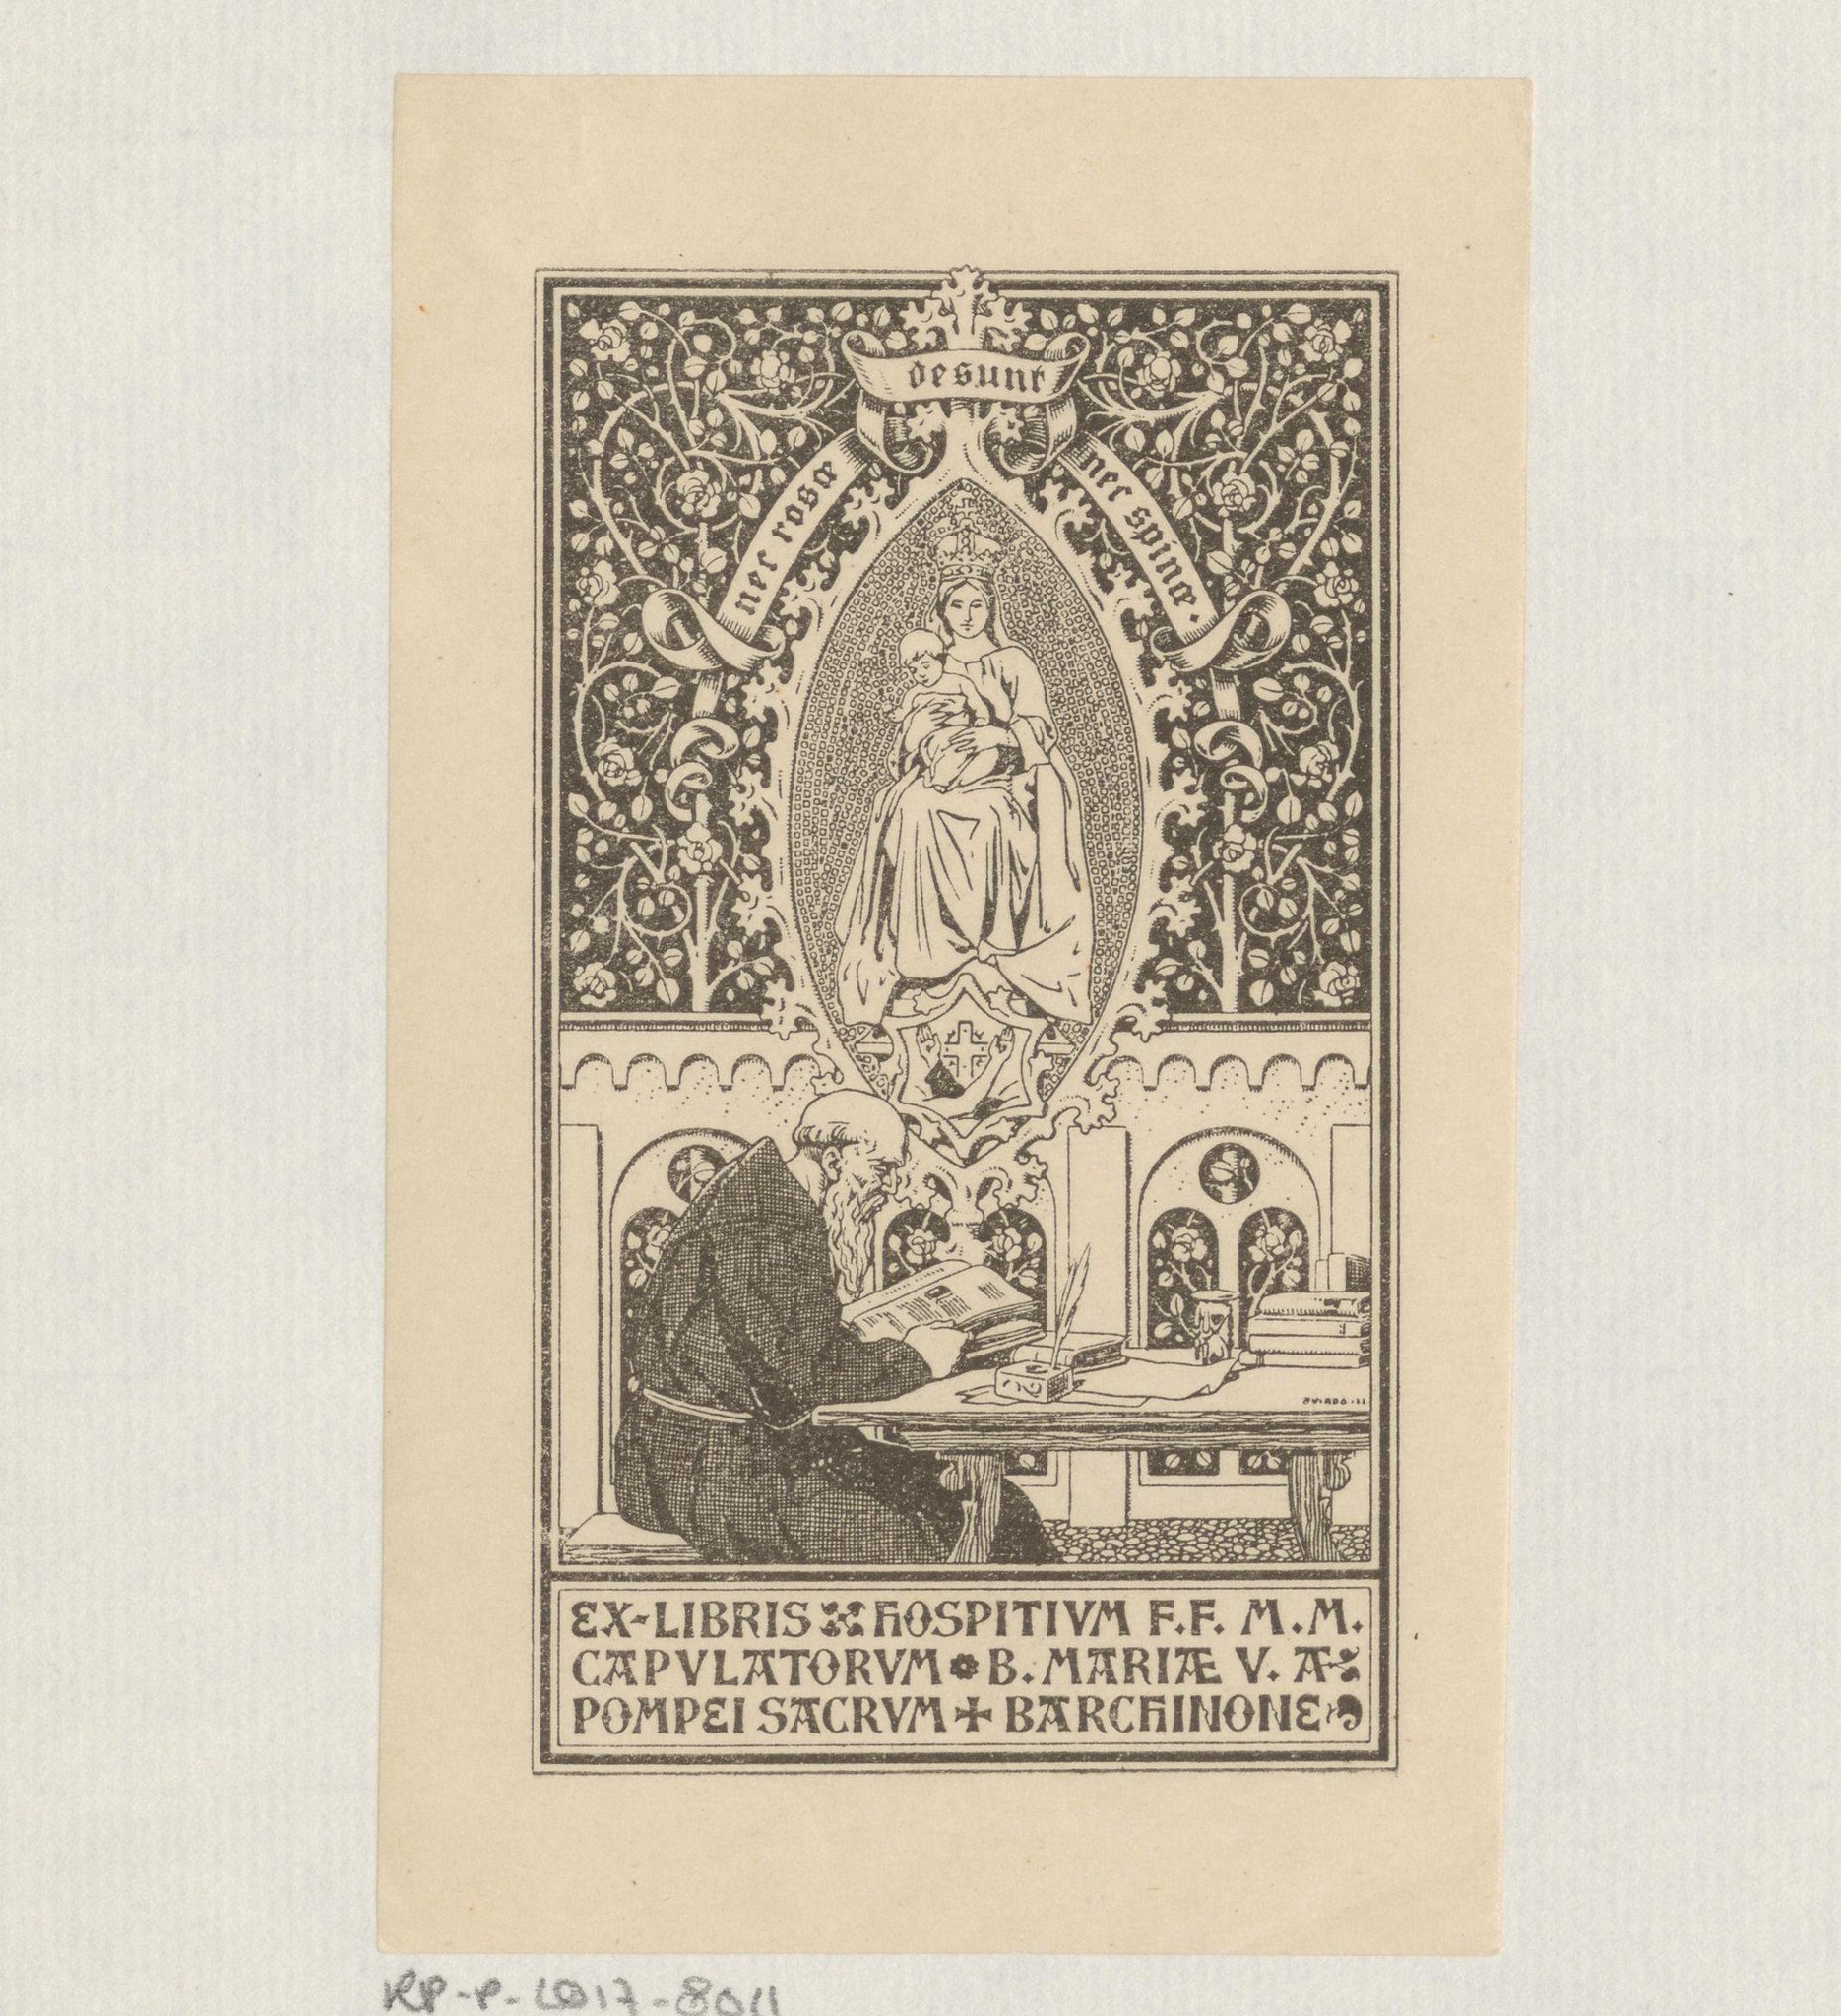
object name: bookplate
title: Ex libris van onbekend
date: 1880-1939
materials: paper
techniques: printing block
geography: spain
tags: madonna: i.e. mary with the christ-child, reading, monk(s), friar(s)